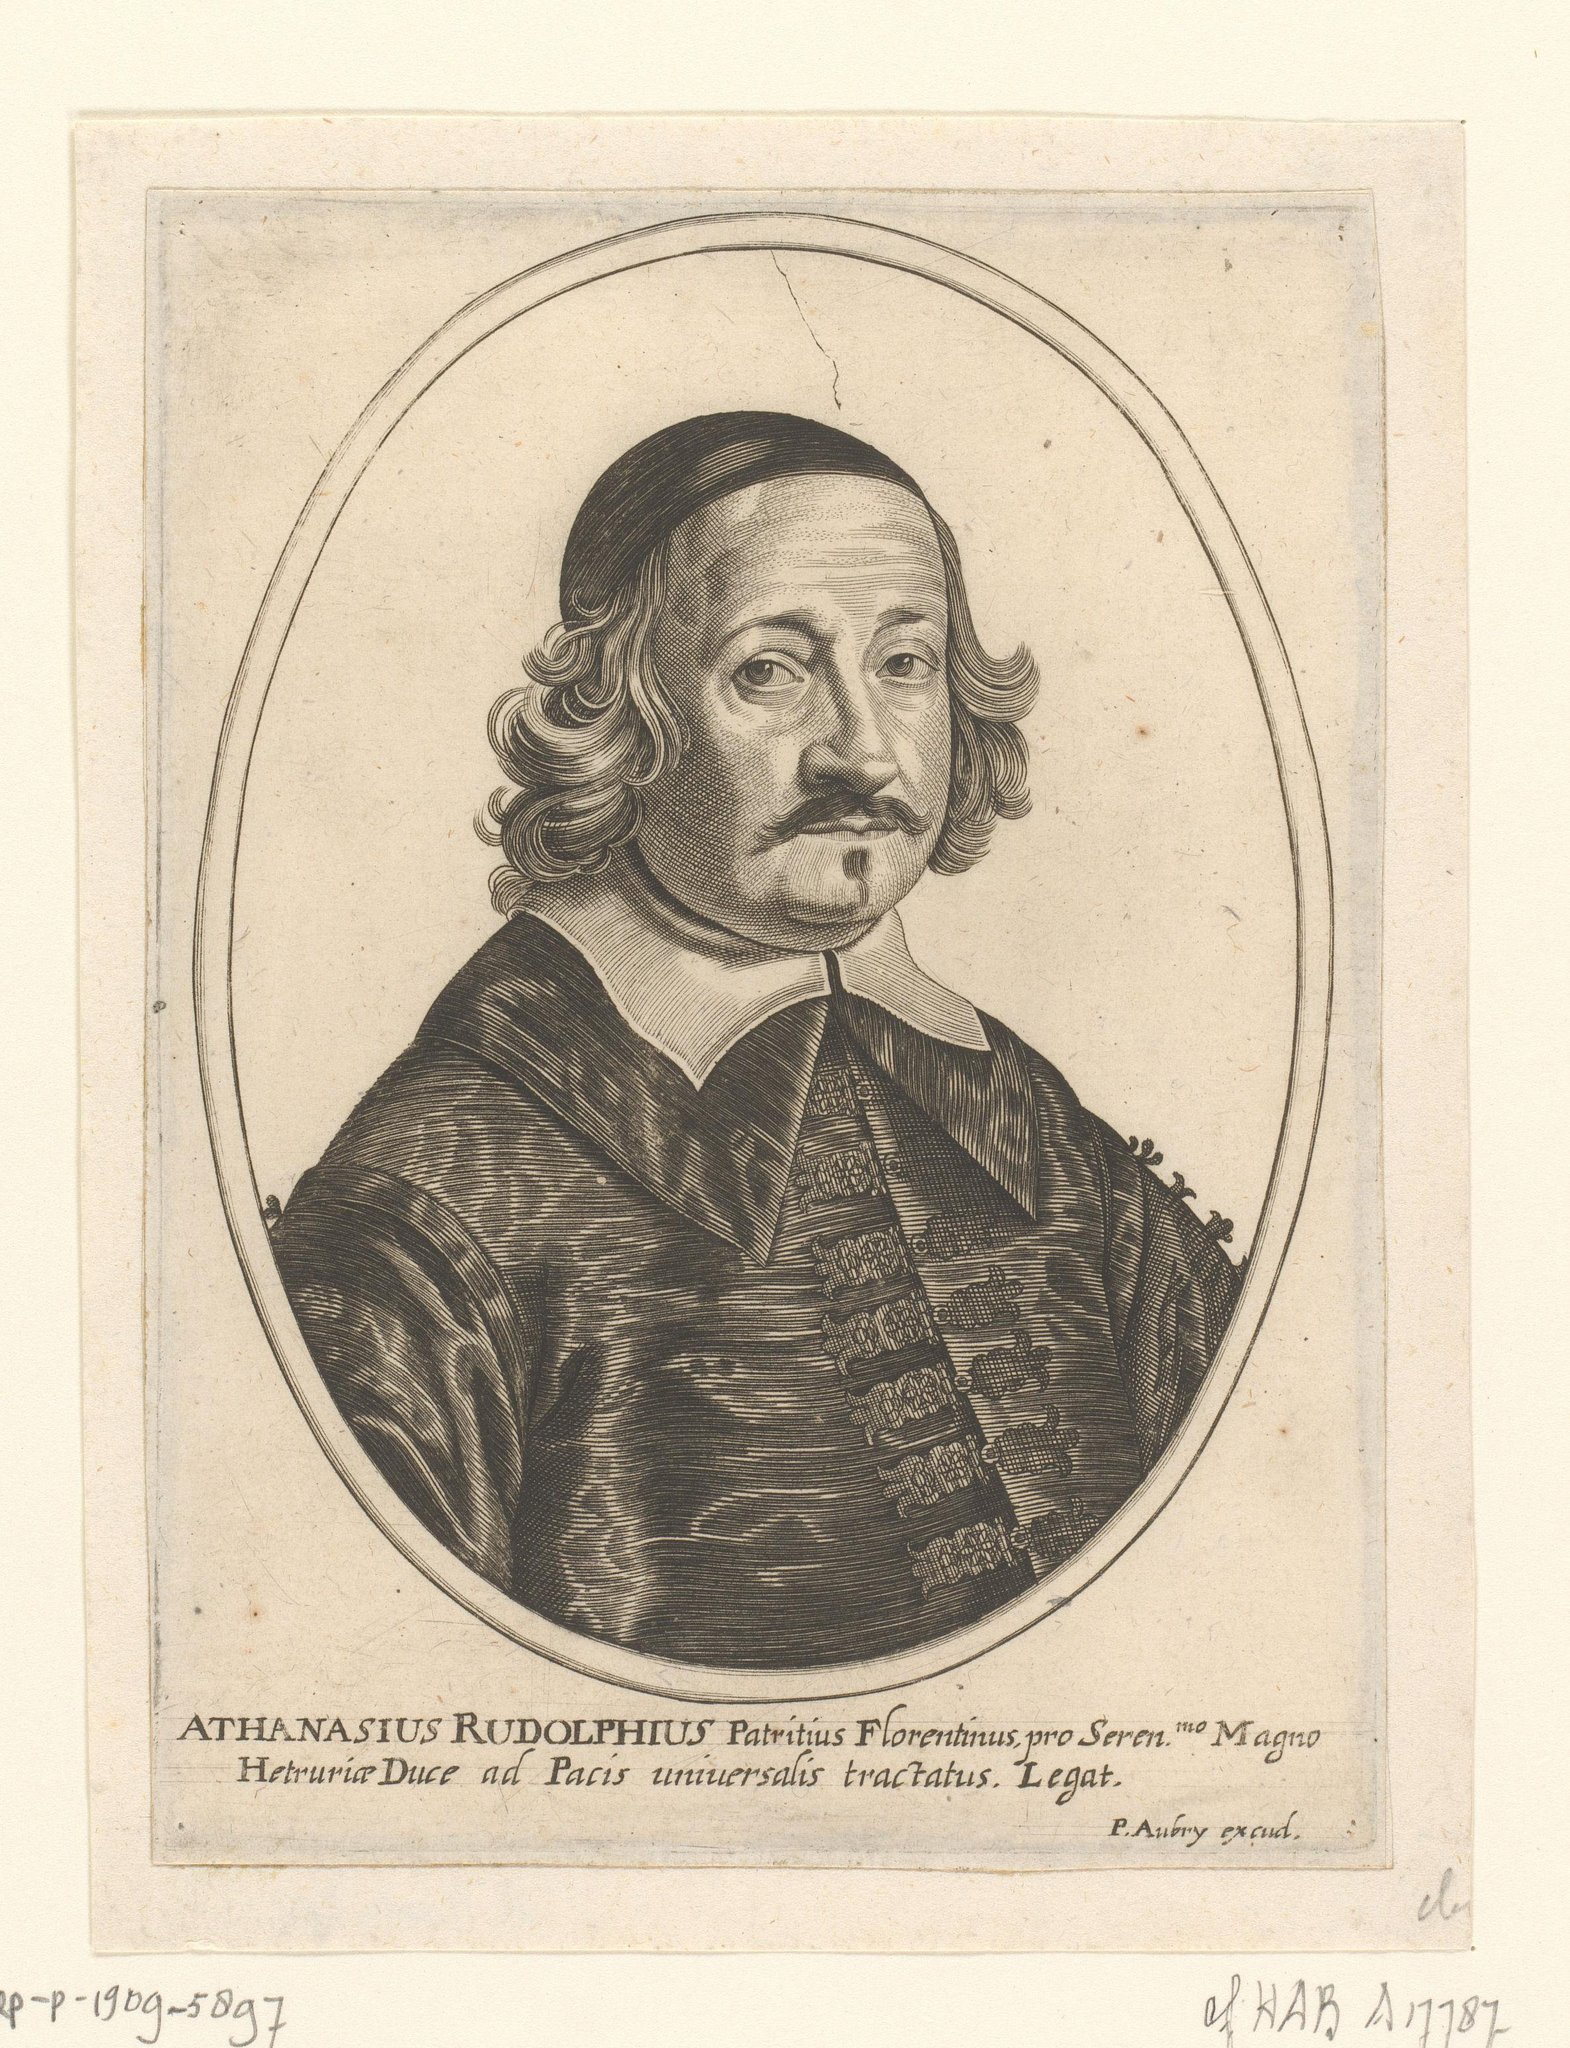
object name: print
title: Portret van Atanasio Rodulfi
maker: Anonymous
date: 1606-1686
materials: paper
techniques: engraving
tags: historical persons, diplomacy, diplomat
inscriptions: collector's mark: Lugt 2228